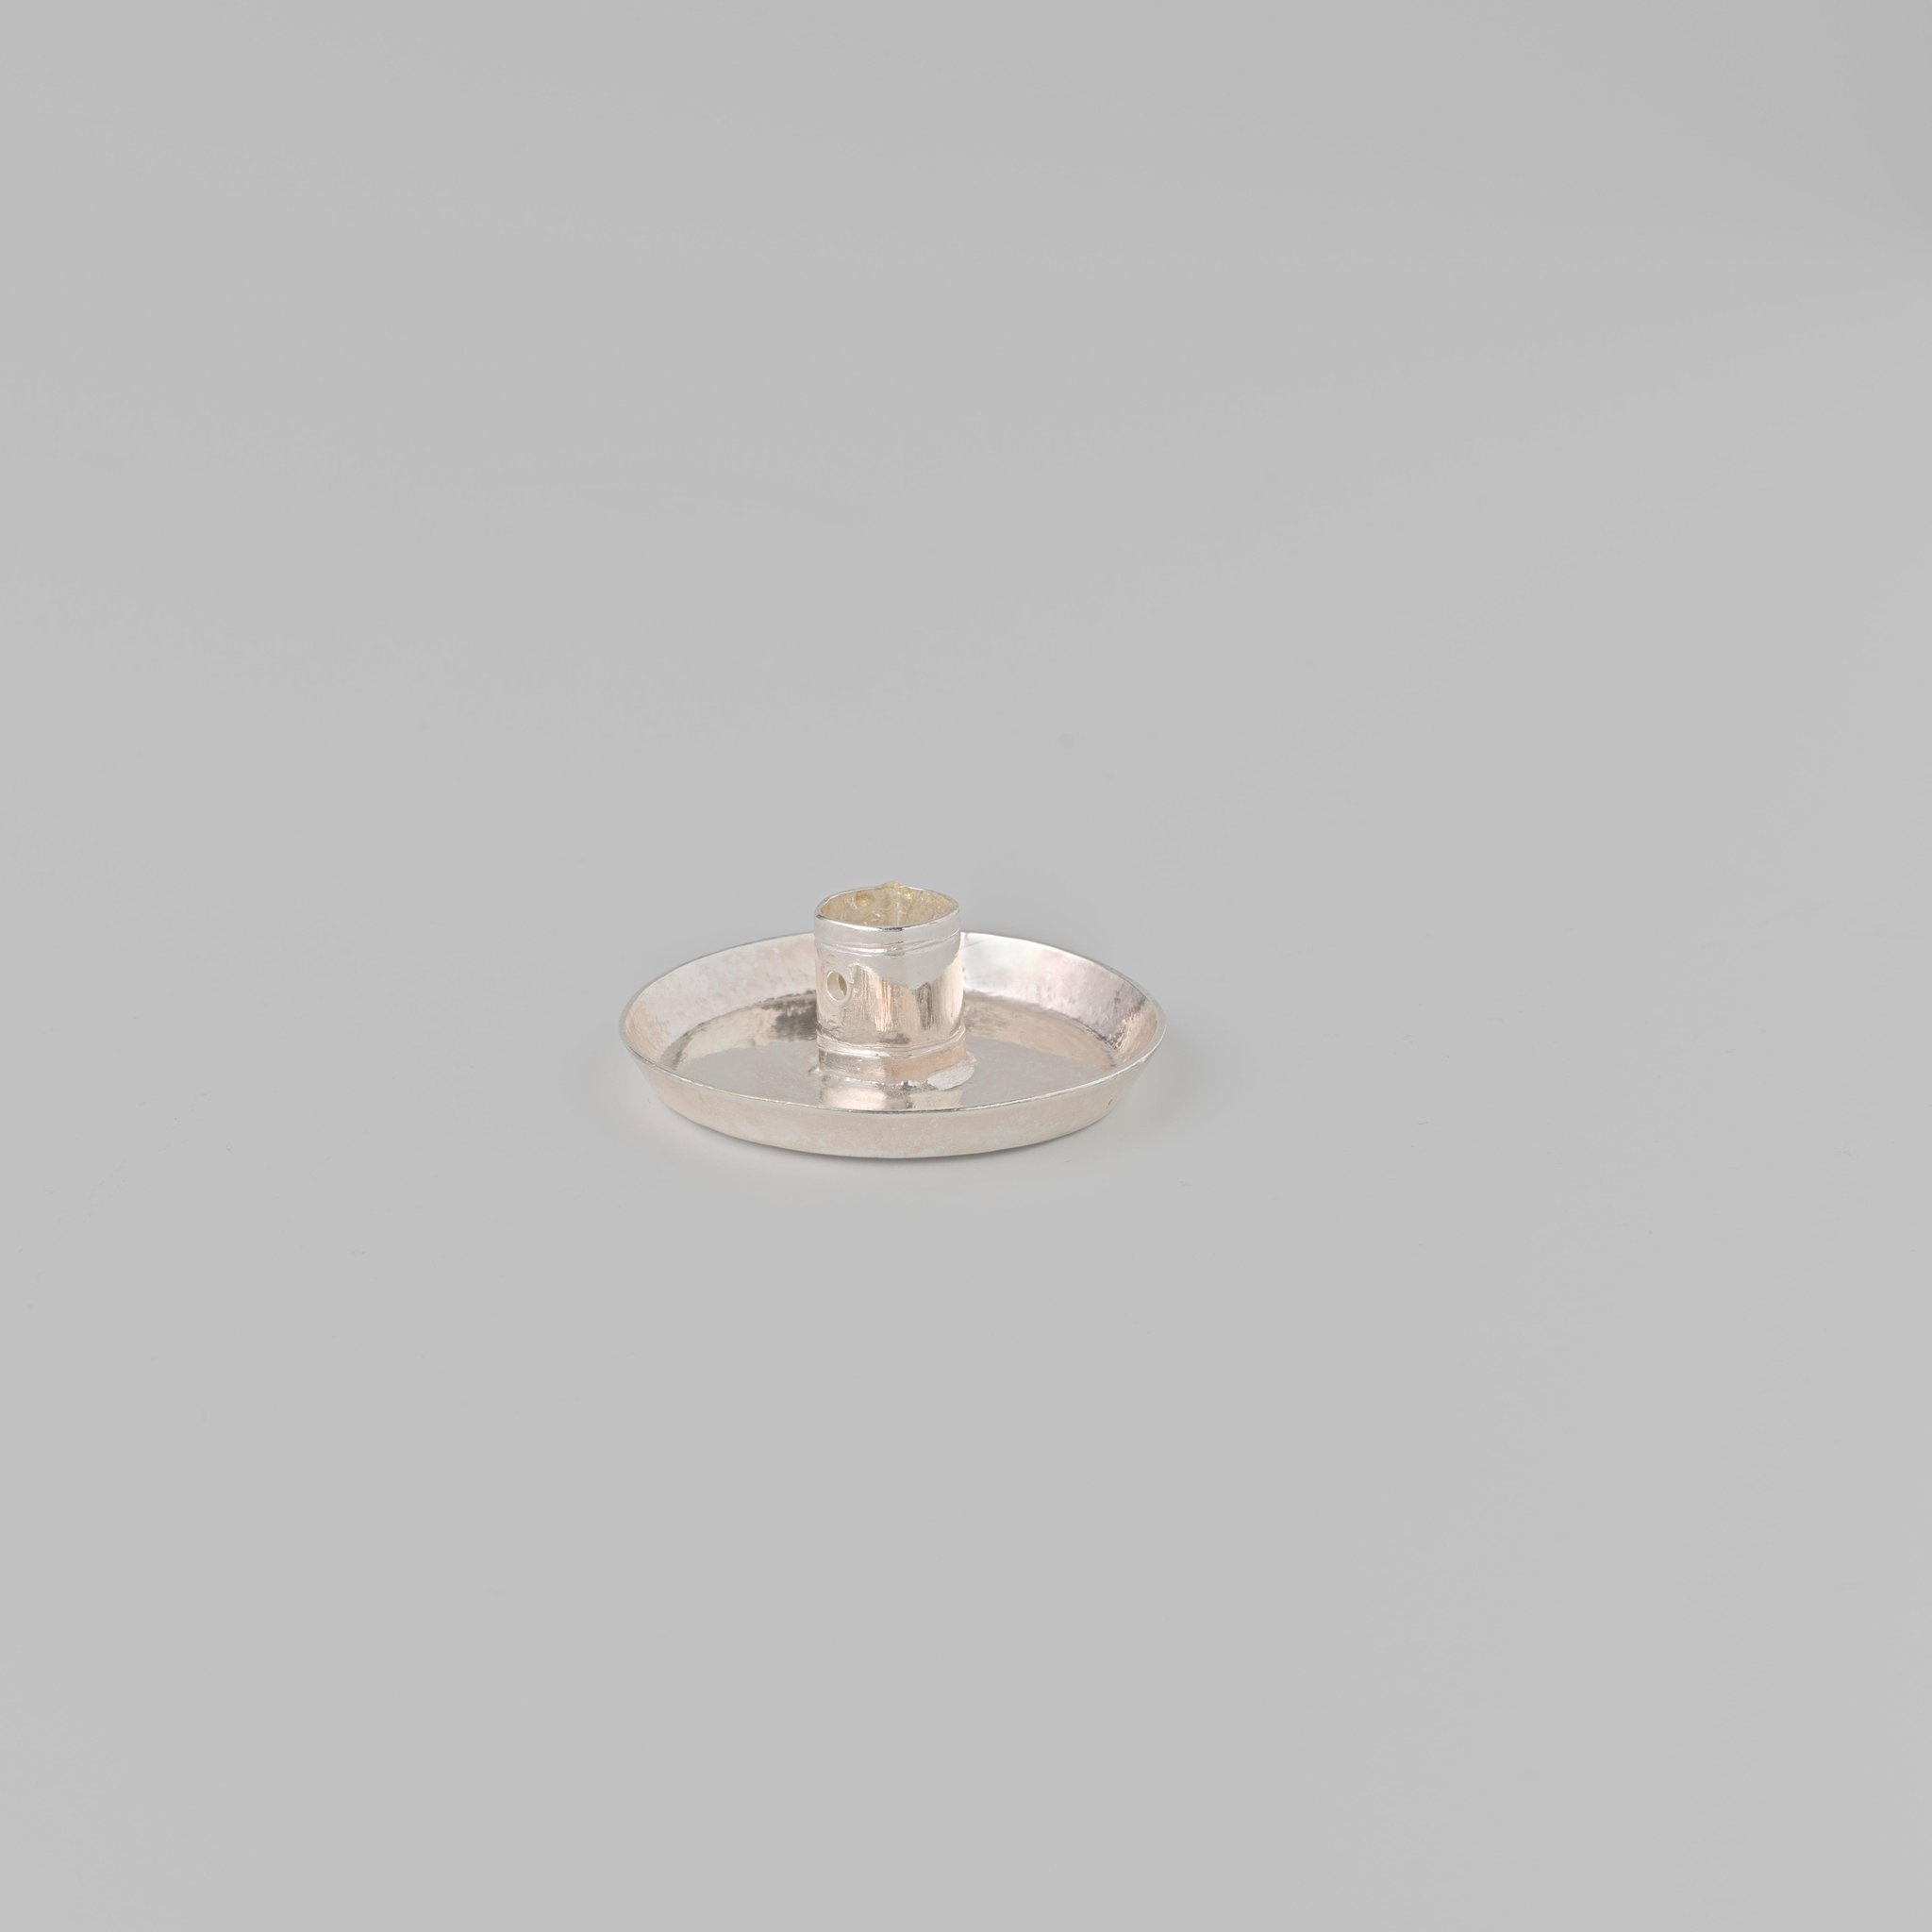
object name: miniature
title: Blaker van zilver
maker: Anonymous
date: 1650-1675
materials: silver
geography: amsterdam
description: Blaker van zilver, zonder handvat. Ronde vetvanger met kaarshouder met twee gaten en groefranden.